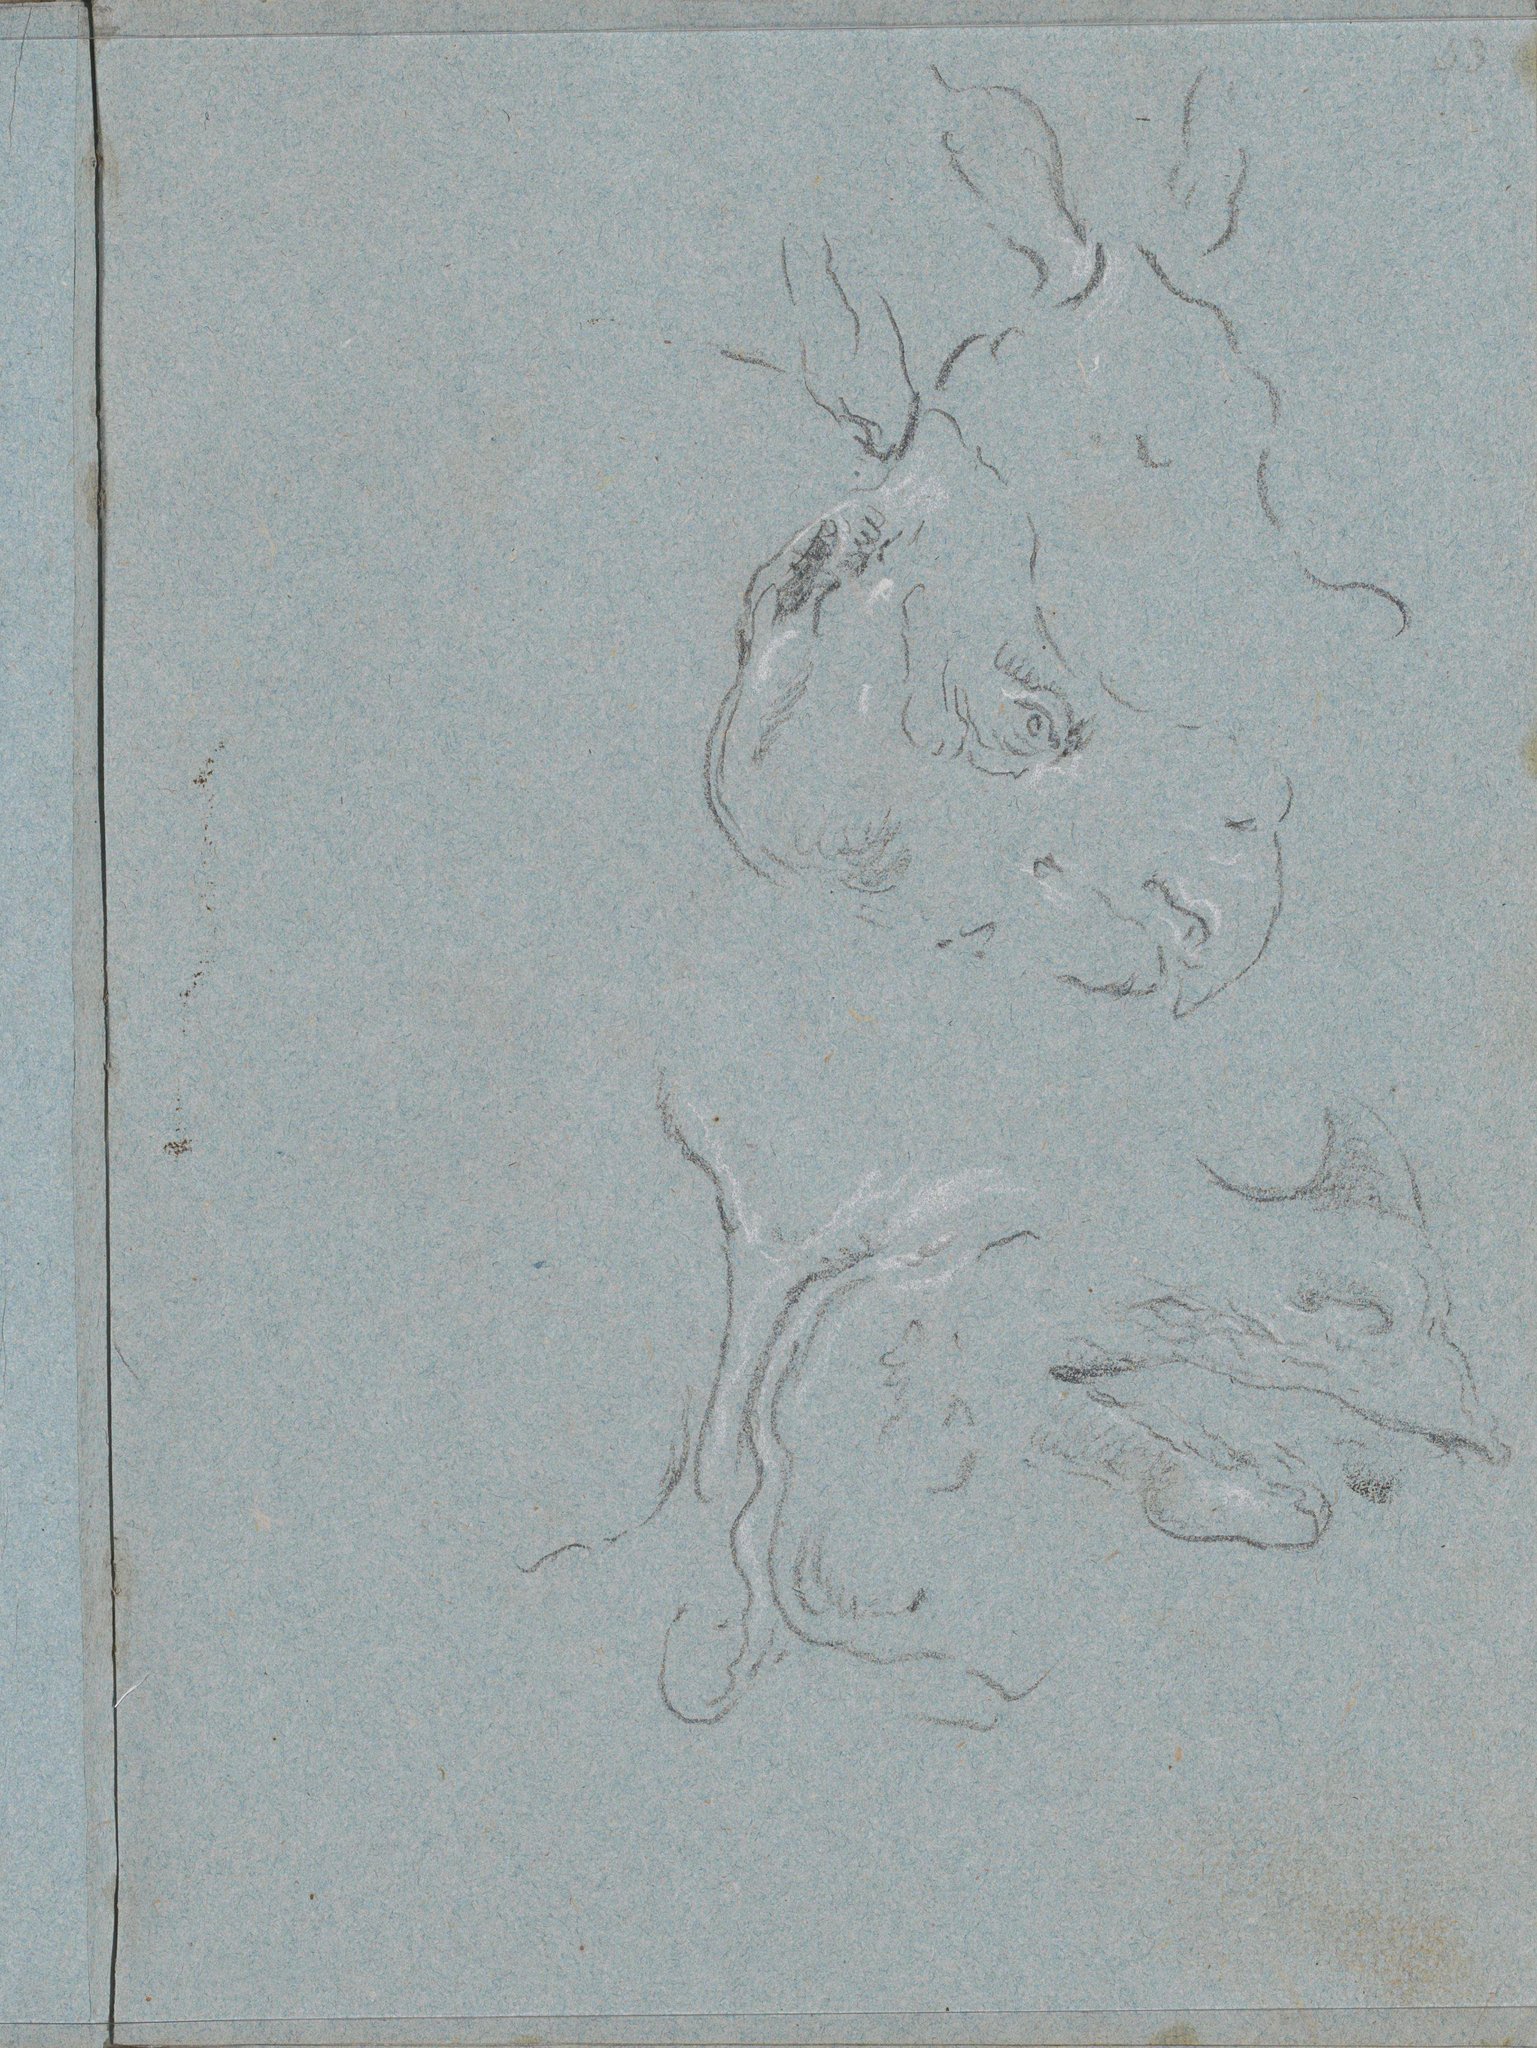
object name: sketchbook leaf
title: Kop van de neushoorn Clara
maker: lorenzo baldissera tiepolo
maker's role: draughtsman, print maker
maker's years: 1736-1776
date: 1751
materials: chalk, paper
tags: london, hoofed animals: rhinoceros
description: Studie naar de neushoorn Clara, die vanaf 1746 een rondreis door Europa maakte (zie documentatie).